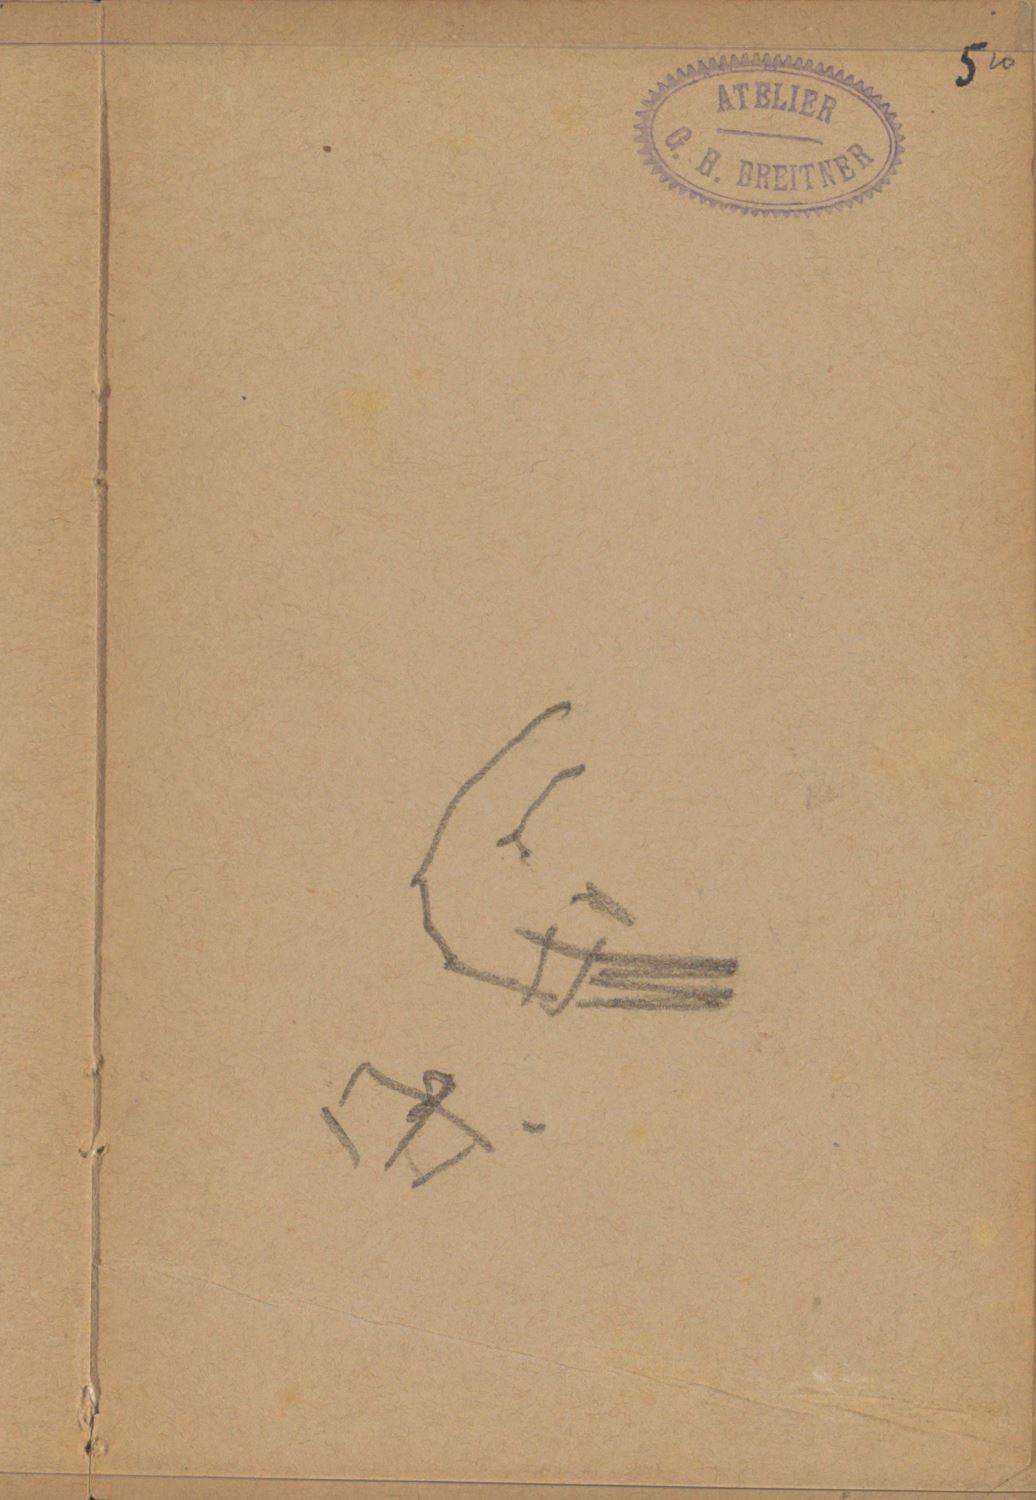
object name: sketchbook leaf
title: Studie, mogelijk van een mannenhoofd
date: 1887-1891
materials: paper, pencil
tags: head (human)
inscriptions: workshop stamp: Lugt 291d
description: Pagina 10 uit een schetsboek met 83 bladen.